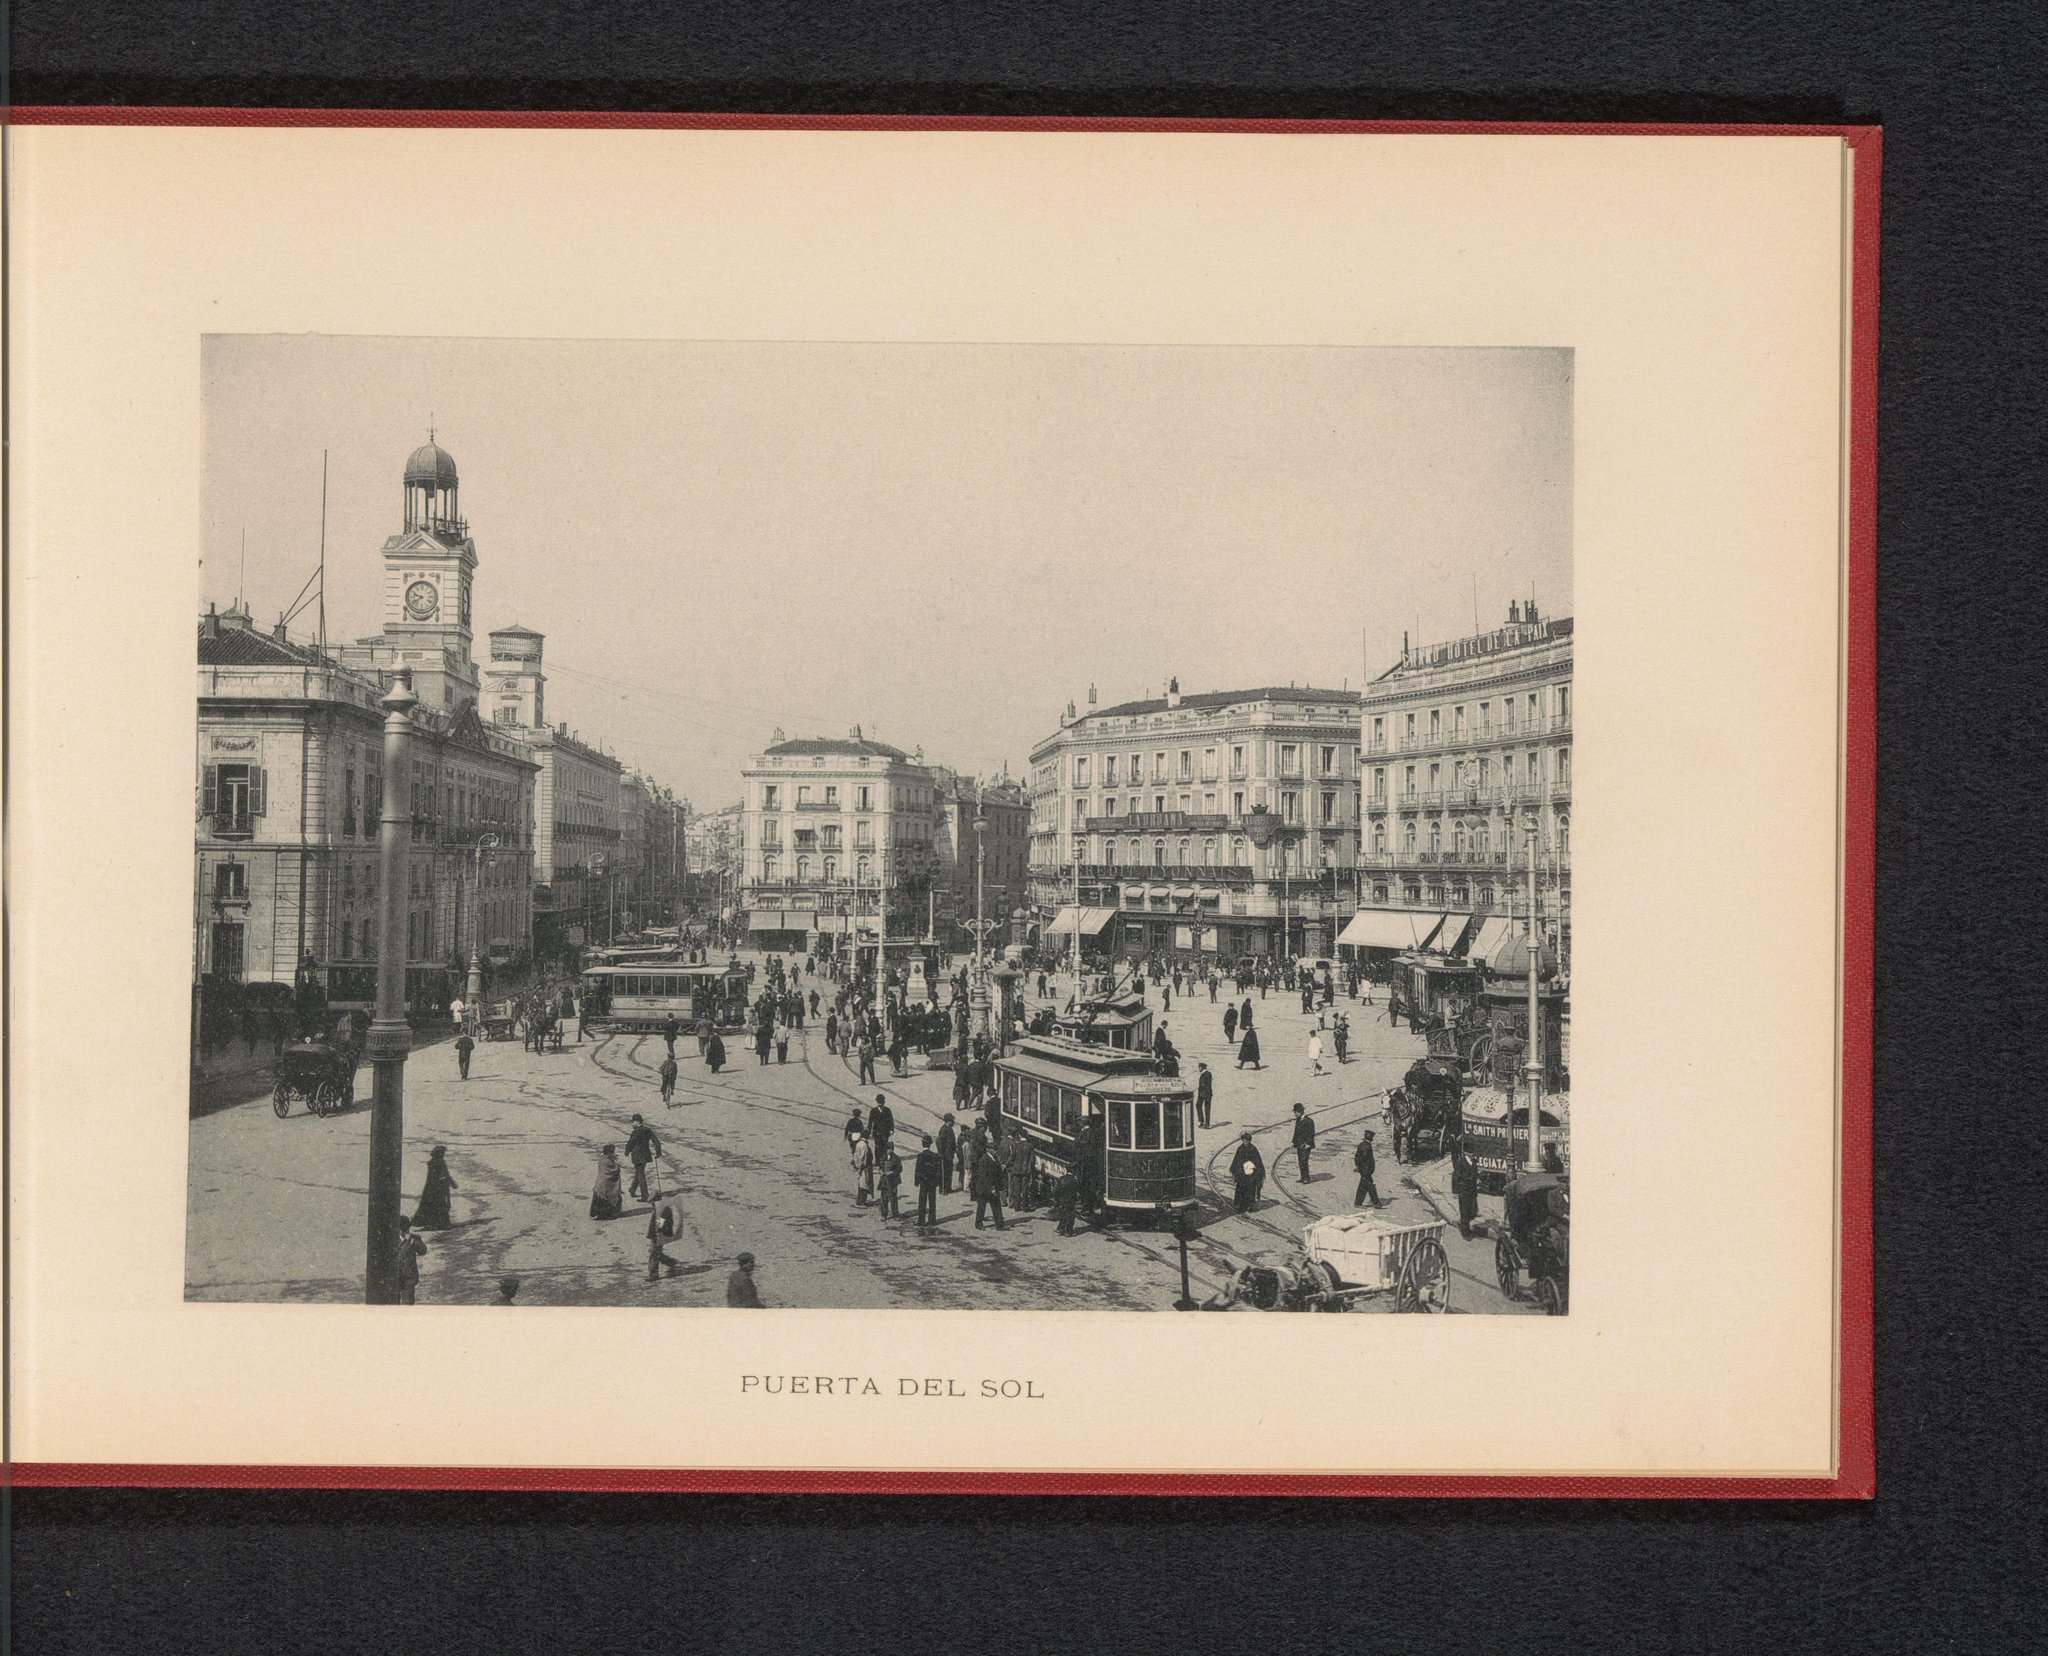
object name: page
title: Gezicht op het Puerta del Sol in Madrid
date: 1888-1898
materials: paper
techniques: photograph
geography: madrid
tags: square, place, circus, etc., tramway, tram